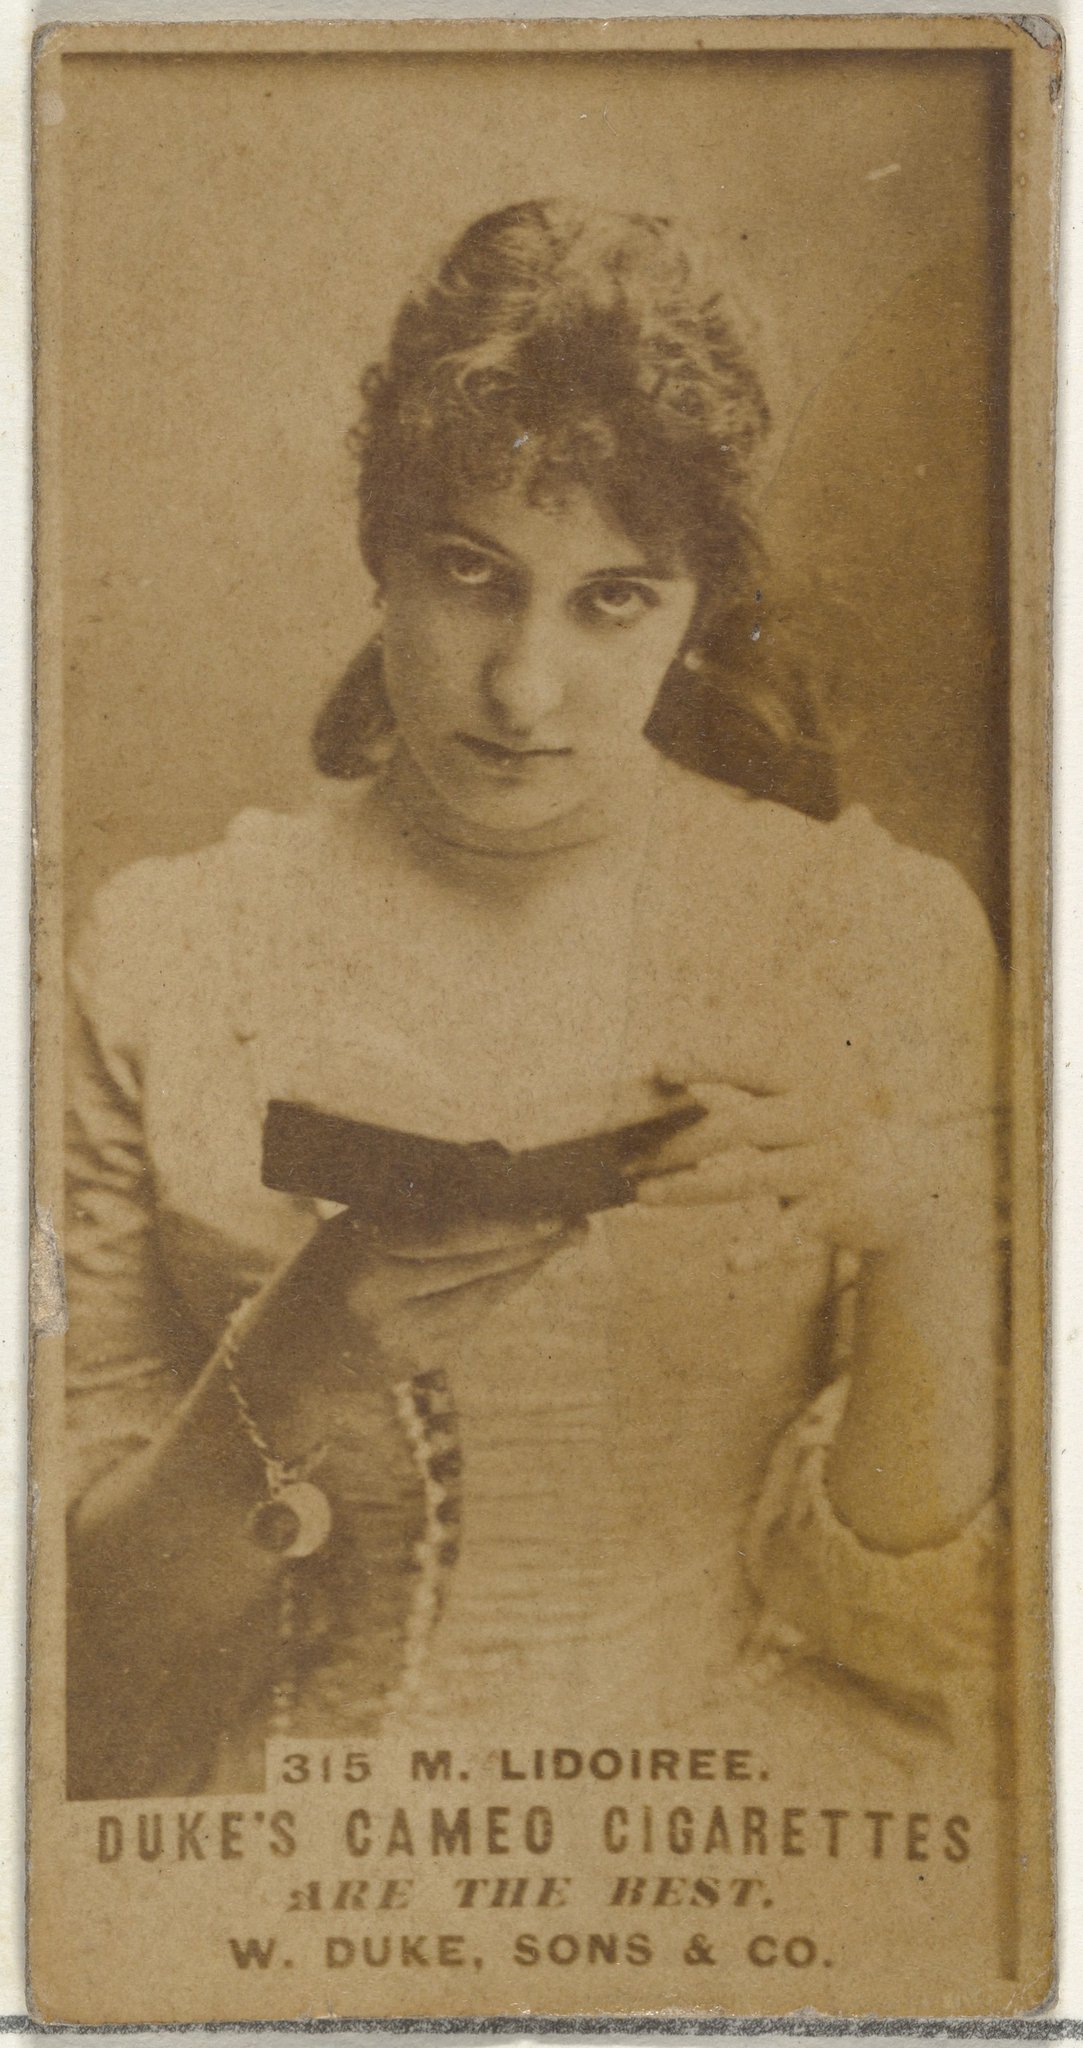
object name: photograph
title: Card Number 315, M. Lidoiree, from the Actors and Actresses series (N145-5) issued by Duke Sons & Co. to promote Cameo Cigarettes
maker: w. duke, sons & co.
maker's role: publisher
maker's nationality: american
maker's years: 1870-1920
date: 1880-1889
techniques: albumen silver print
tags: portraits,women,actresses